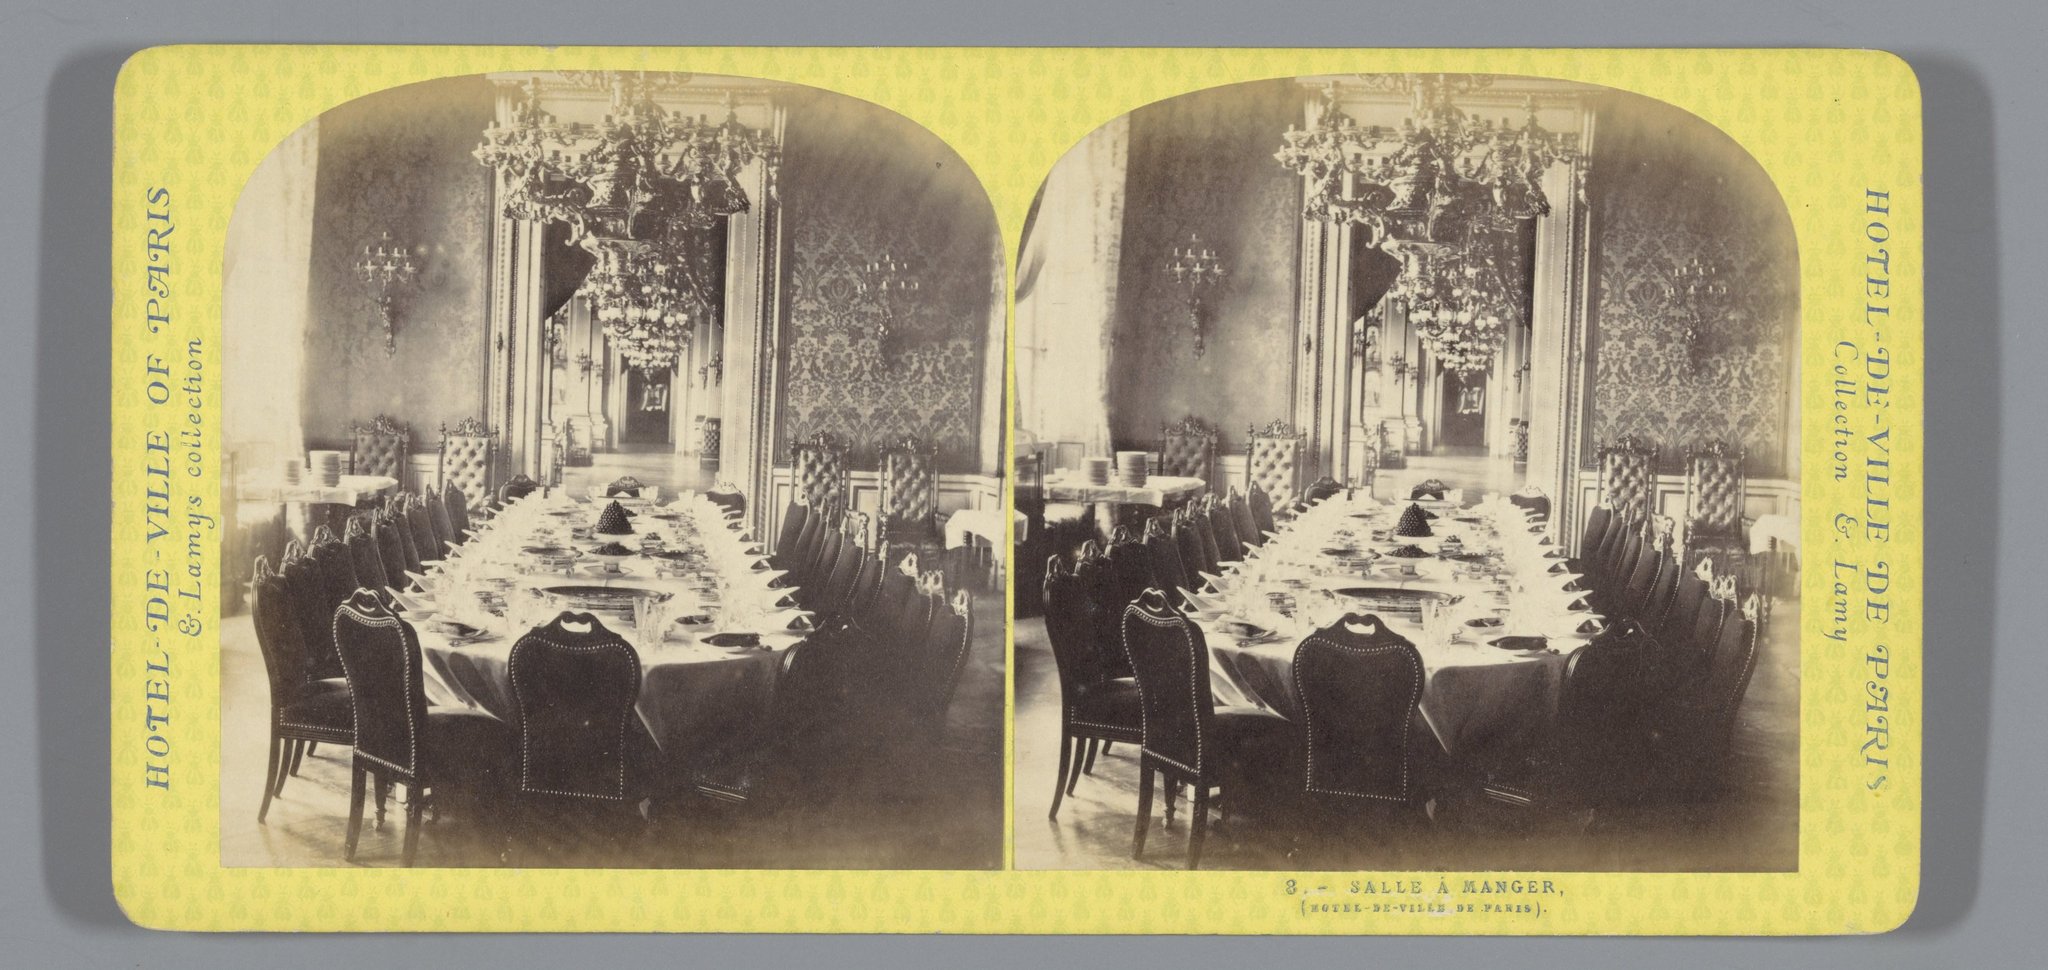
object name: stereograph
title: Hotel-de-ville of Paris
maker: ernest eléonor pierre lamy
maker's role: publisher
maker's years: 1828-1900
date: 1860-1880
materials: cardboard, photographic support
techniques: albumen print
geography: paris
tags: interior ~ representation of a building, dining-room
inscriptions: number: ‘8.’, inscription: ‘E. Lamy's collection’